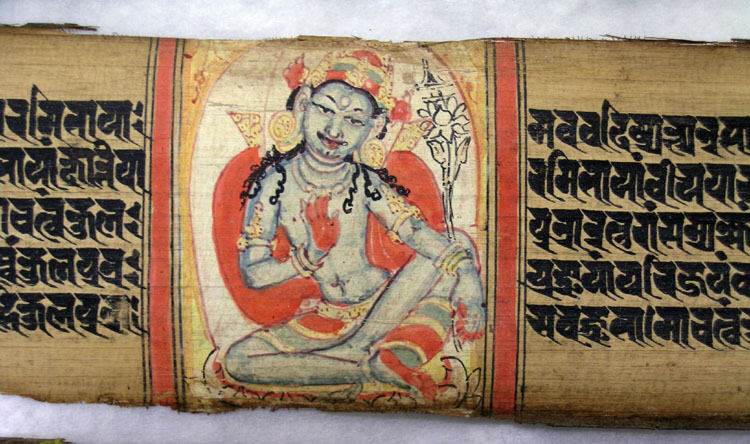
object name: folio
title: Bodhisattva Padmapani, Leaf from a dispersed Ashtasahasrika Prajnaparamita (Perfection of Wisdom) Manuscript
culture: indian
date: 1101-1200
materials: ink, leaf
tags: buddhism,bodhisattvas